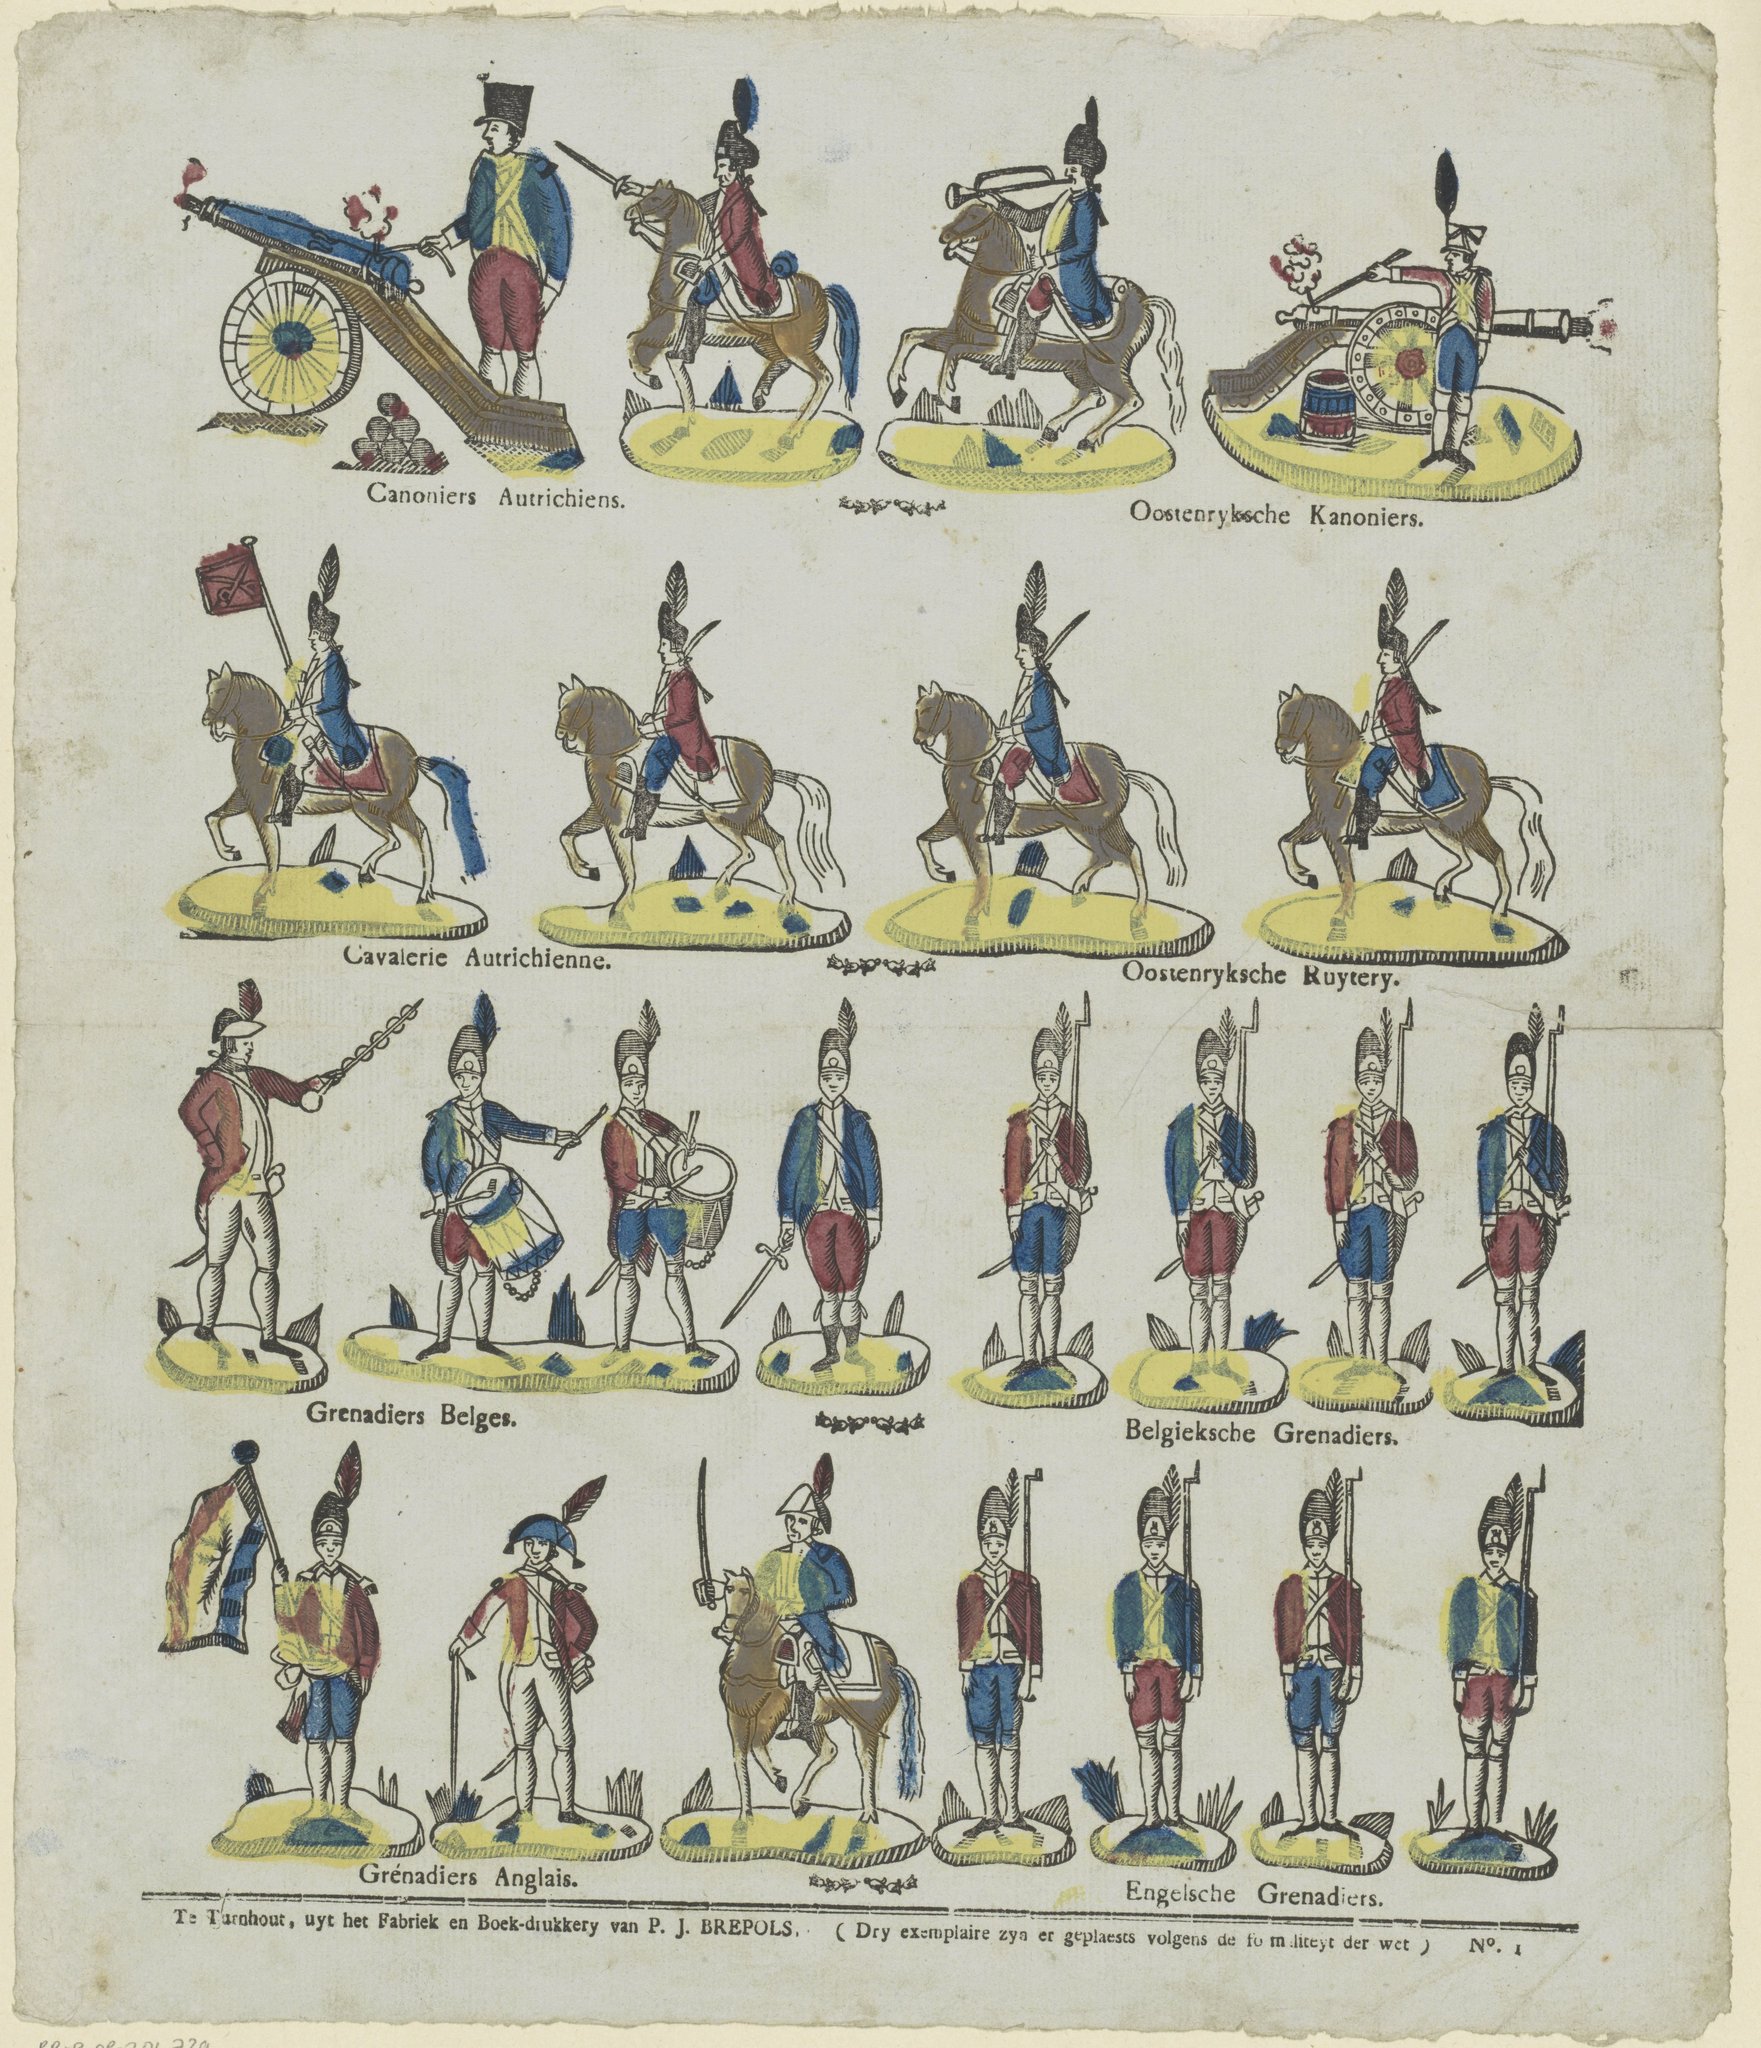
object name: popular print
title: Militairen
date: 1800-1833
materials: paper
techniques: colour, letterpress printing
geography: turnhout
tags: weapons, warfare; military affairs (+ cavalry, horsemen), the soldier; the soldier's life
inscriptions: collector's mark: Lugt 2760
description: Blad met 4 horizontale rijen met met in totaal 23 militairen, te paard, met wapens en met vlaggen uit Oostenrijk, België en Engeland. Onder de voorstellingen onderschriften in het Nederlands en in het Frans. Genummerd rechtsonder: No. 1.